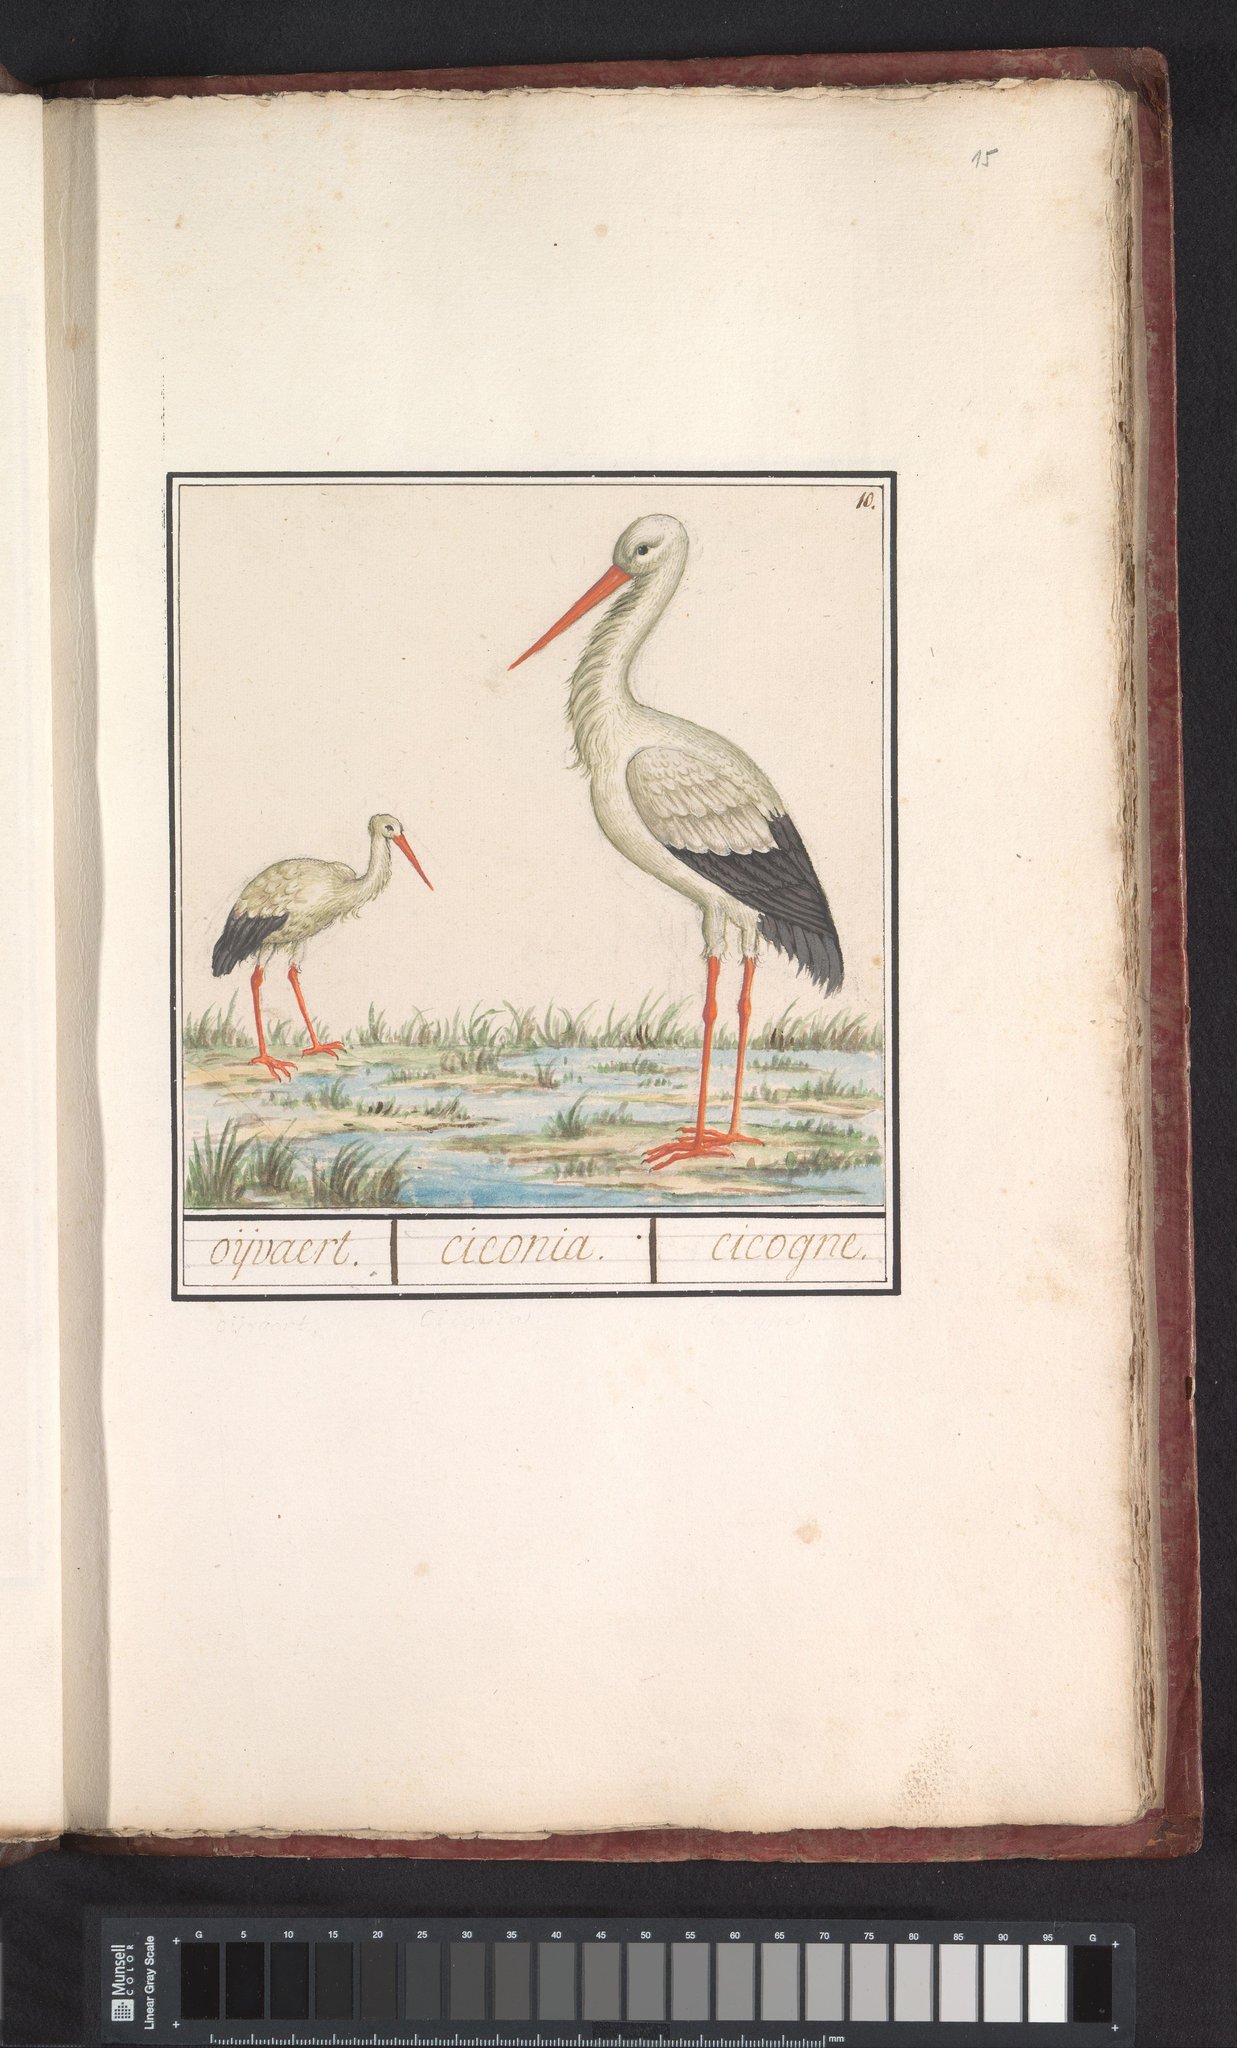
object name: drawing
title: Ooievaar (Ciconia ciconia)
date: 1596-1610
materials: chalk, paint, paper, pencil, watercolor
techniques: brush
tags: shore-birds and wading-birds: stork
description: Ooievaars. Genummerd rechtsboven: 10. Onderdeel van het derde album met tekeningen van vogels. Vijfde van twaalf albums met tekeningen van dieren, vogels en planten bekend rond 1600, gemaakt in opdracht van keizer Rudolf II. Met toelichting in Nederlands, Latijn en Frans.